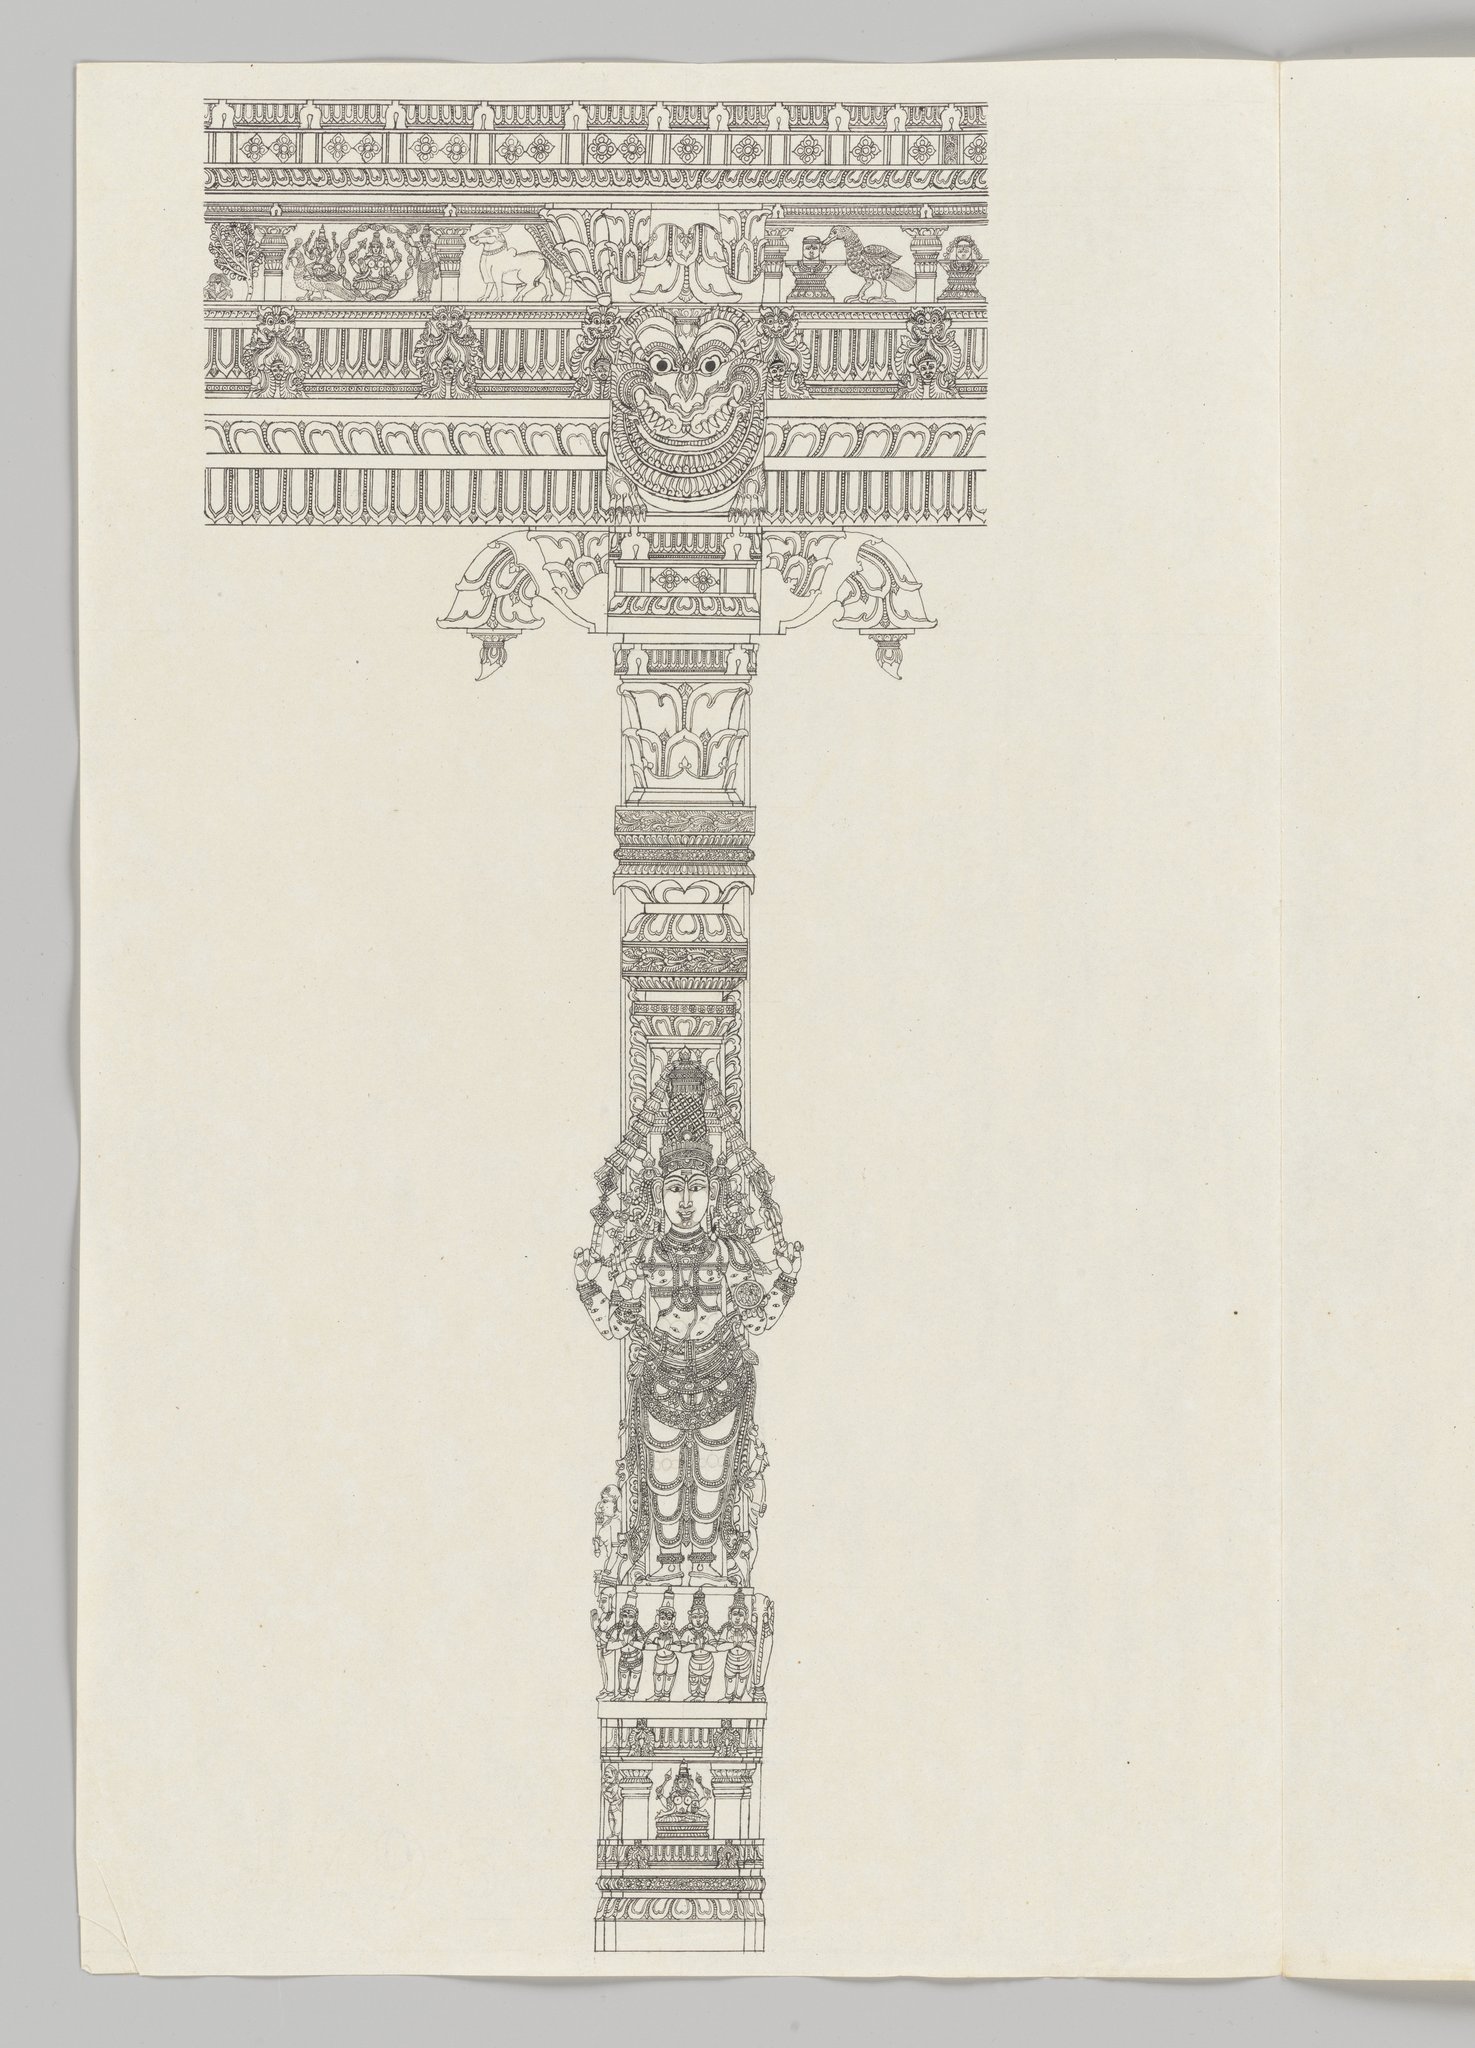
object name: drawing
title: Subramanya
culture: indian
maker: unidentified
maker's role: artist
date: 1800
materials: ink, paper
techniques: wash